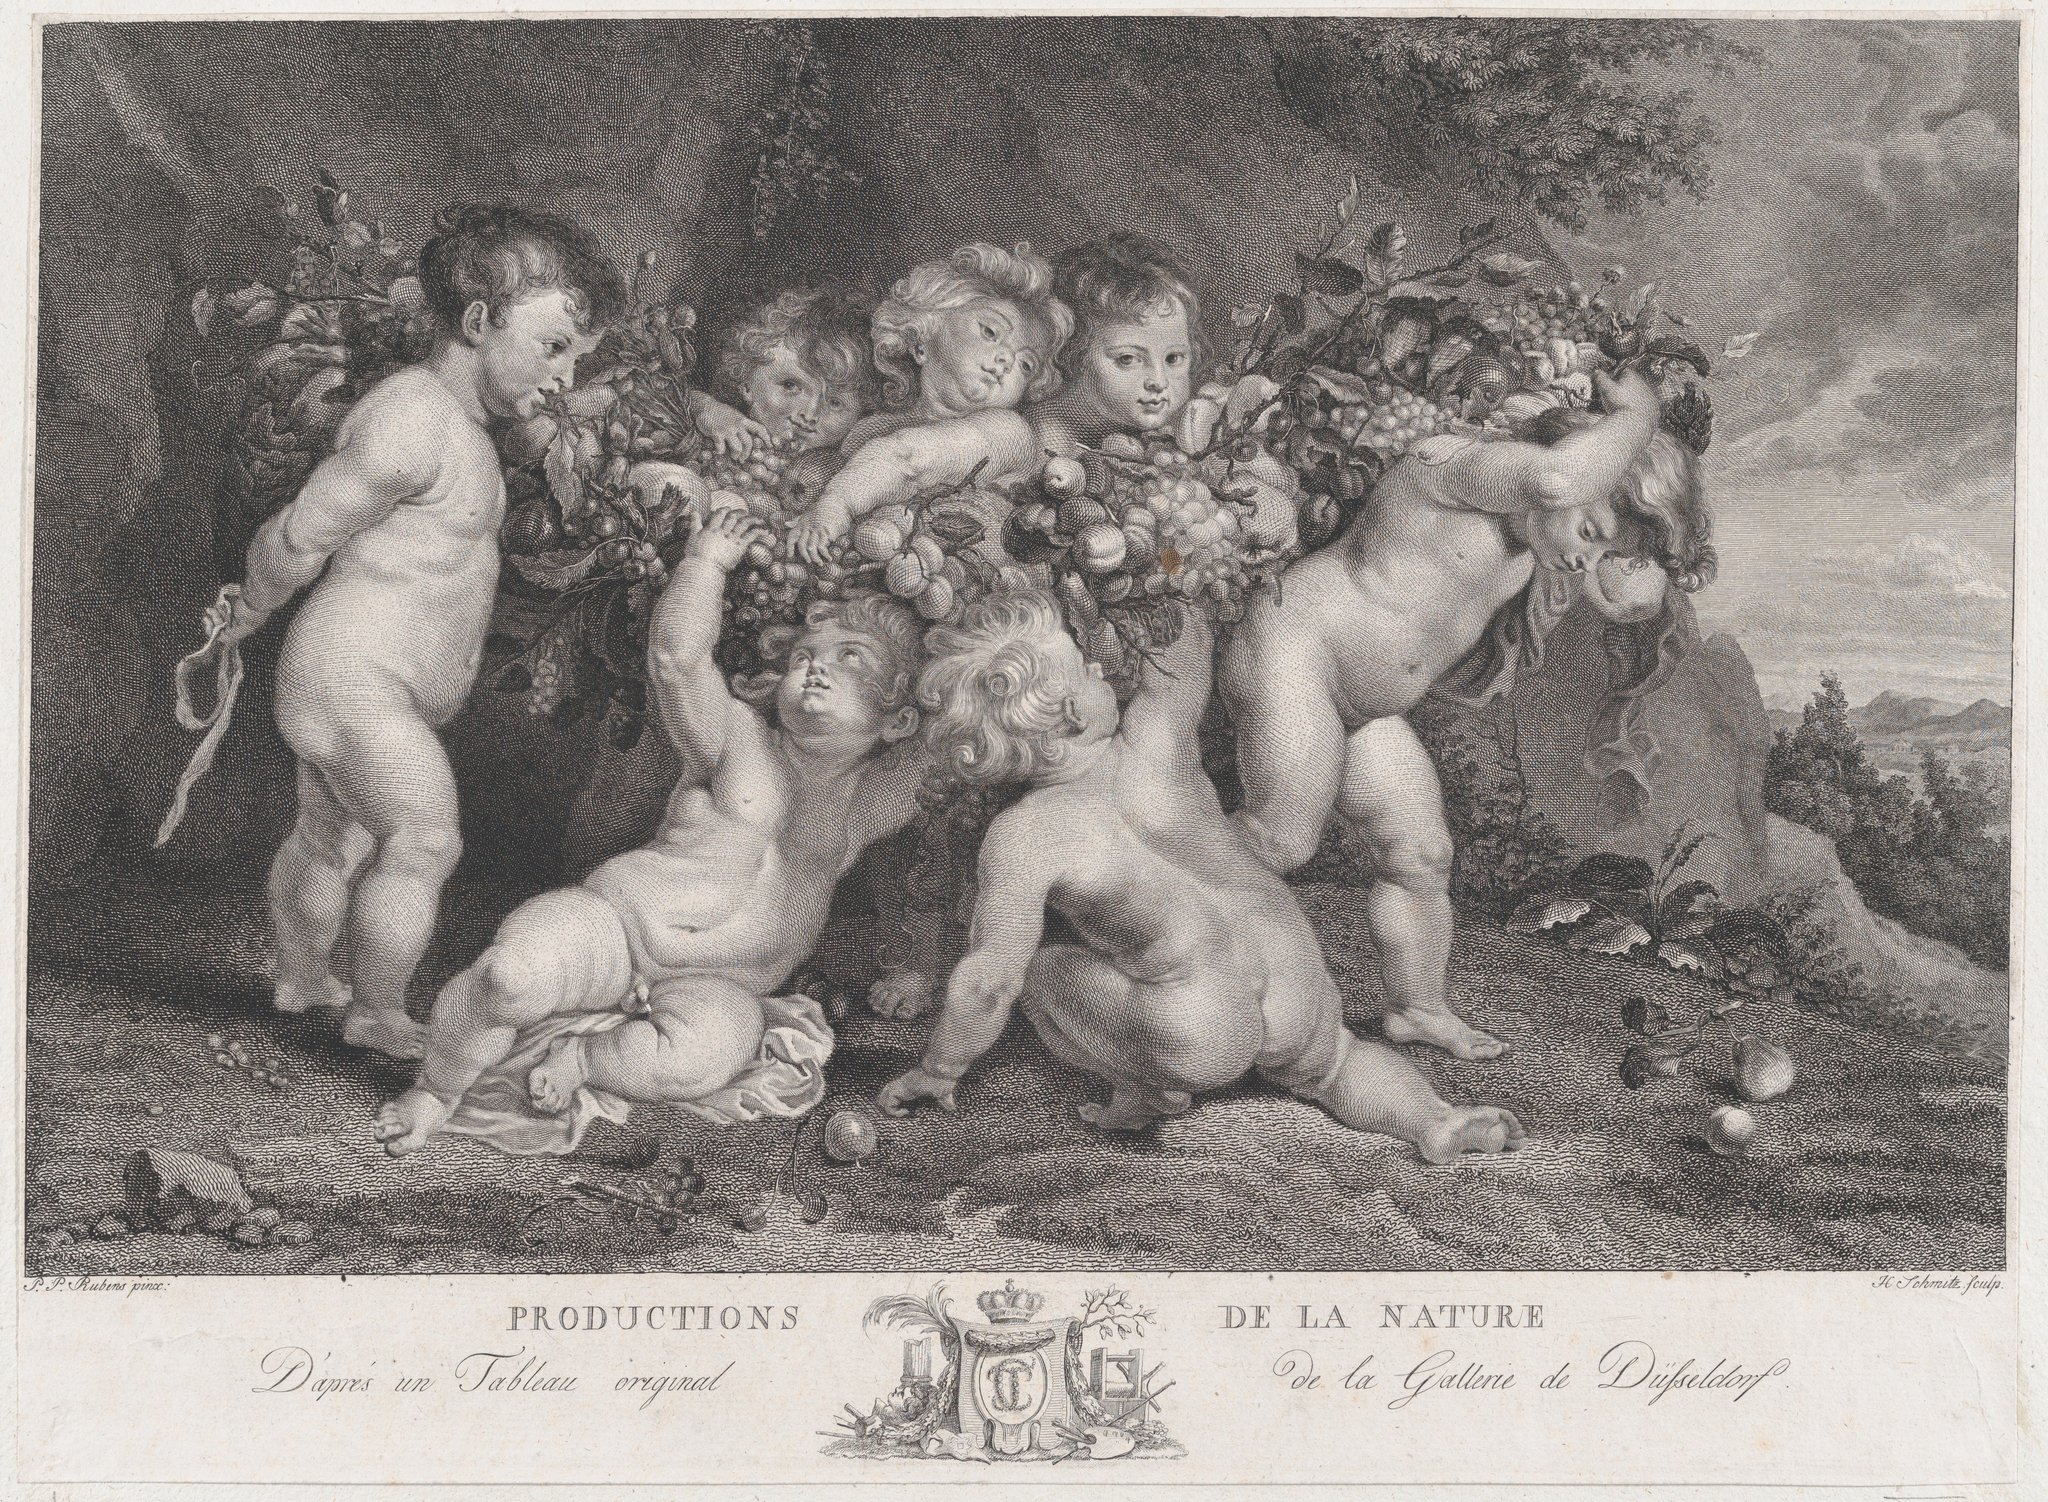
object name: print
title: Seven putti carrying a garland of fruit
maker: heinrich schmitz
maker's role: artist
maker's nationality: german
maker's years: 1758-1787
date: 1780-1787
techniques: engraving, etching